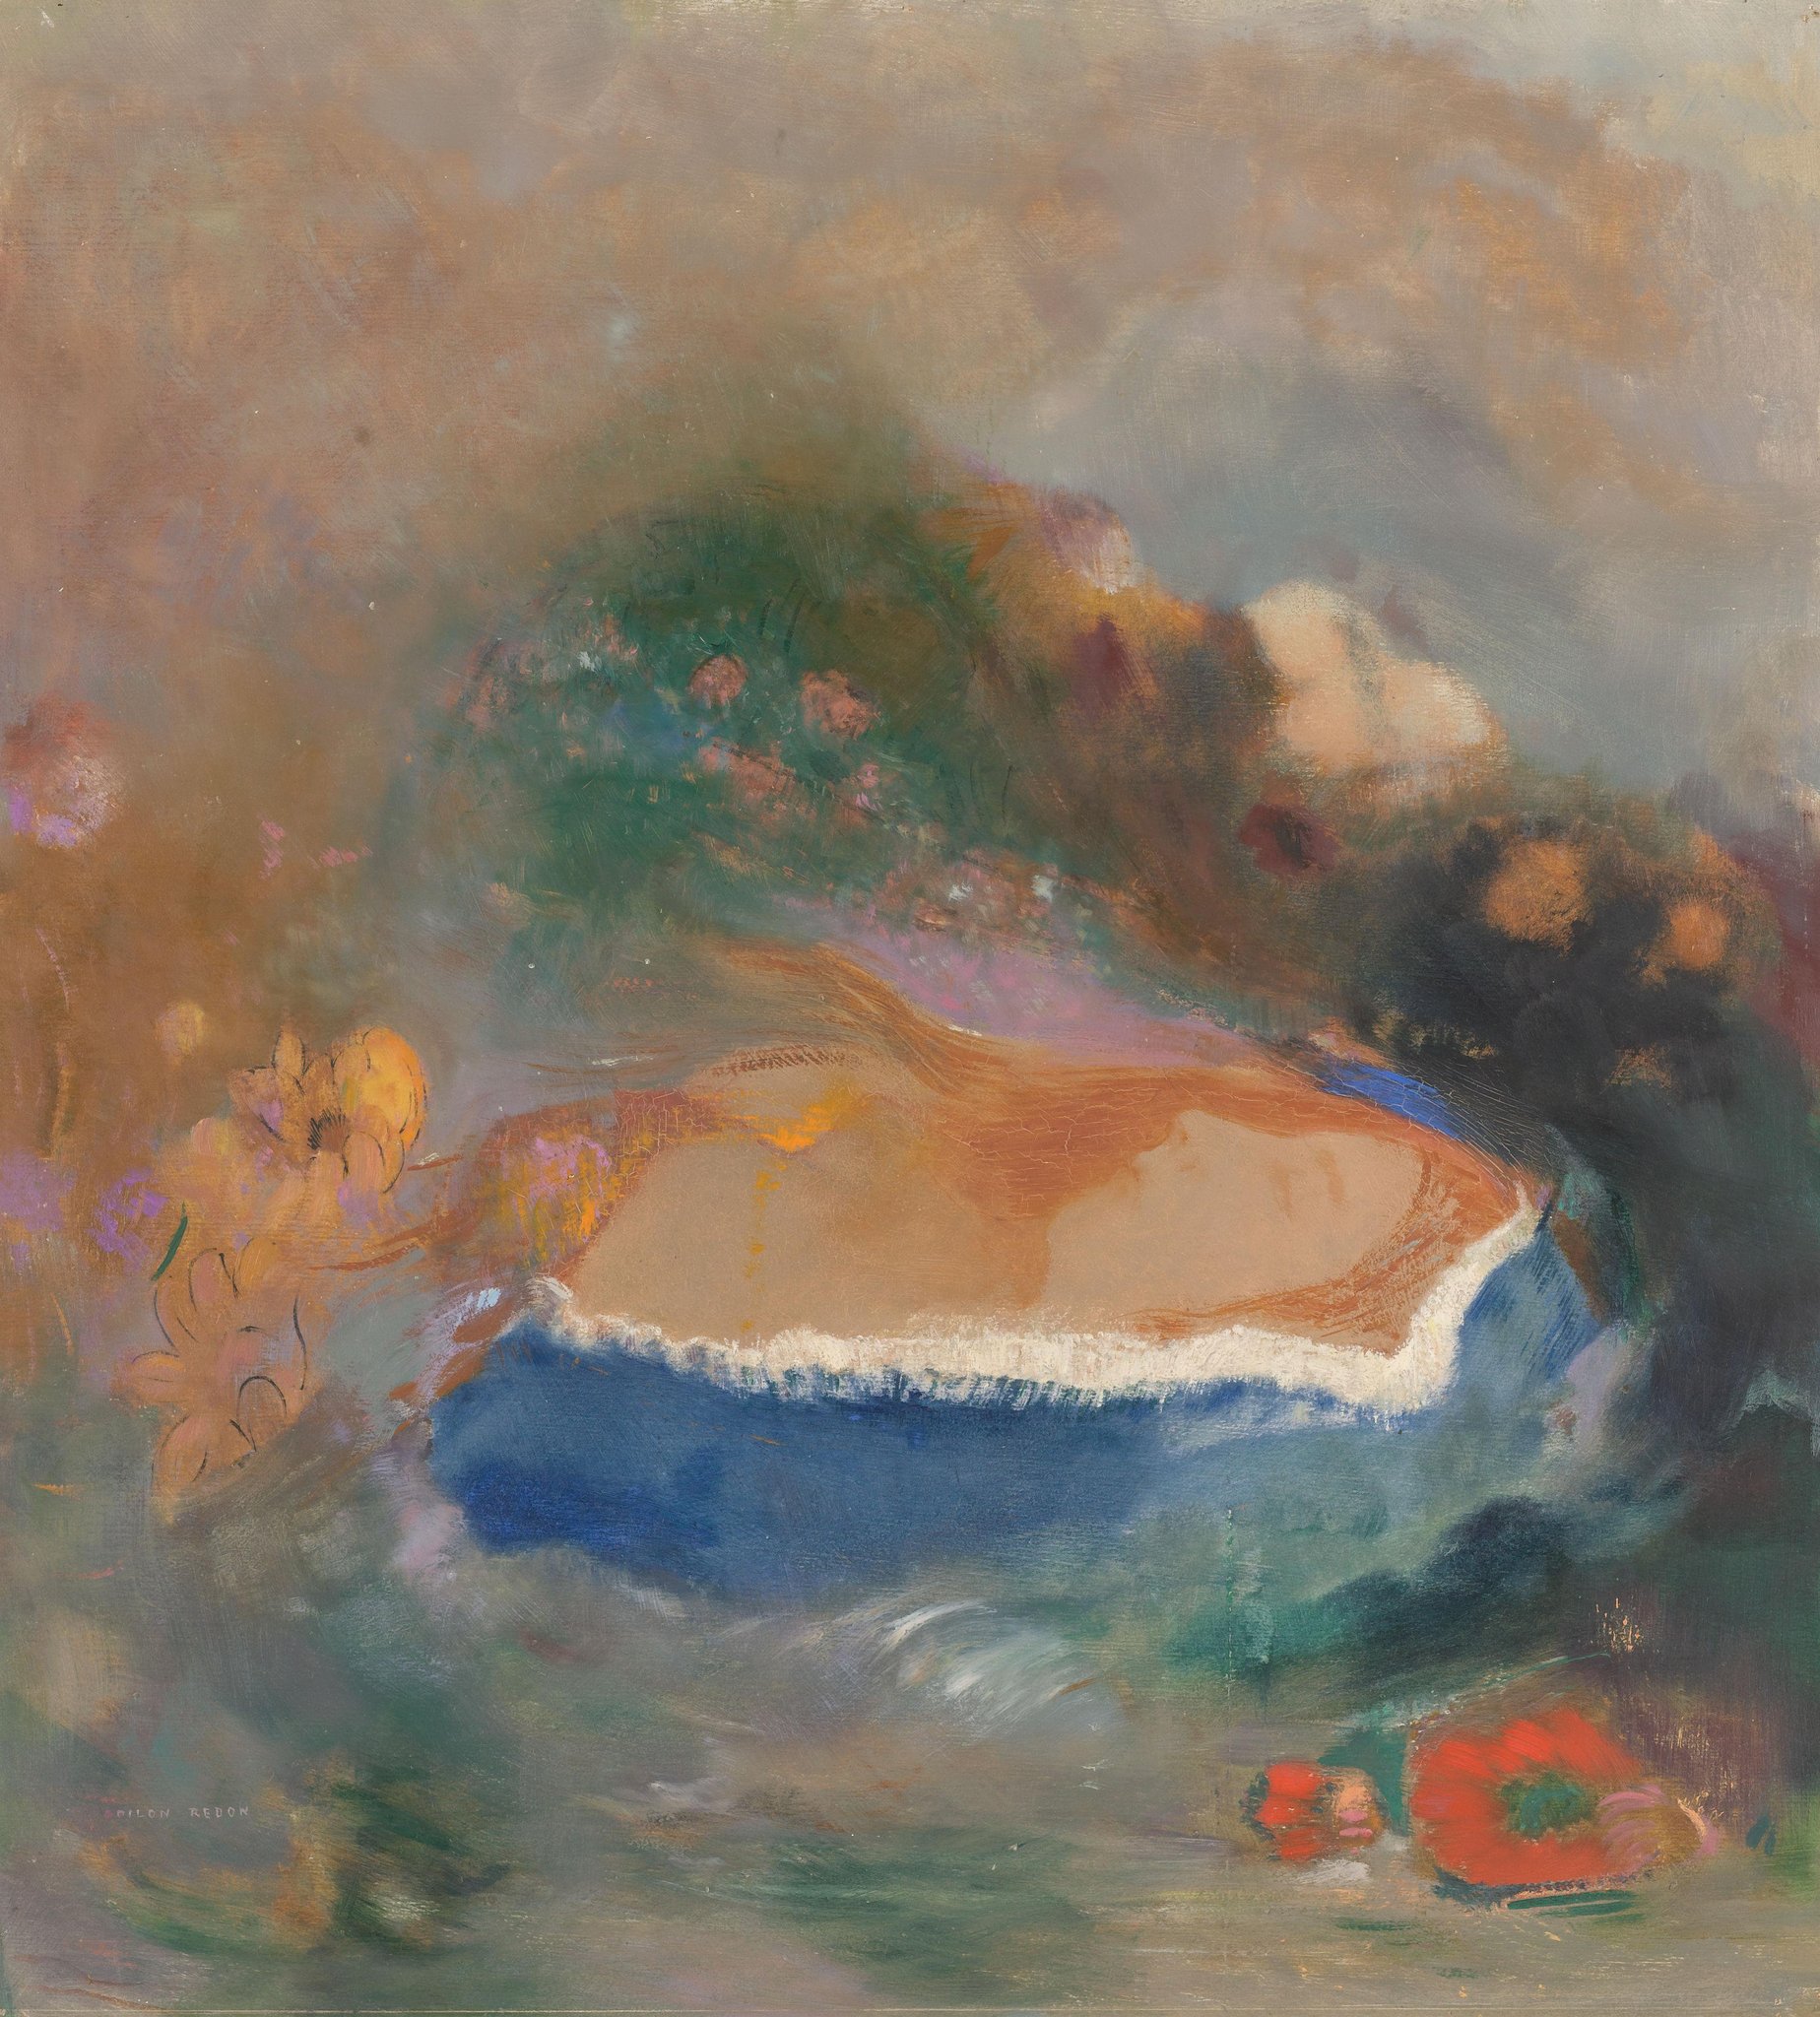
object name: painting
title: Ophélie, la cape bleue sur les eaux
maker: odilon redon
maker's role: draughtsman, painter, print maker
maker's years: 1840-1916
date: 1900-1905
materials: oil, paper, pastel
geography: france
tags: drowned person, (scenes from) specific works of literature (with author, title), ophelia, seeking death, suicide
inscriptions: signature: ‘Odilon Redon’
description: Around 1900 young artists exhibited at various independent societies. Les Vingt in Brussels was such an association, of which both James Ensor and Jan Toorop were members and where Redon was invited to show his work. His dreamy, visionary art is part of Symbolism. Here he depicted the fatal drowning of Ophelia, the lover of Hamlet from the Shakespearean tragedy of the same title.